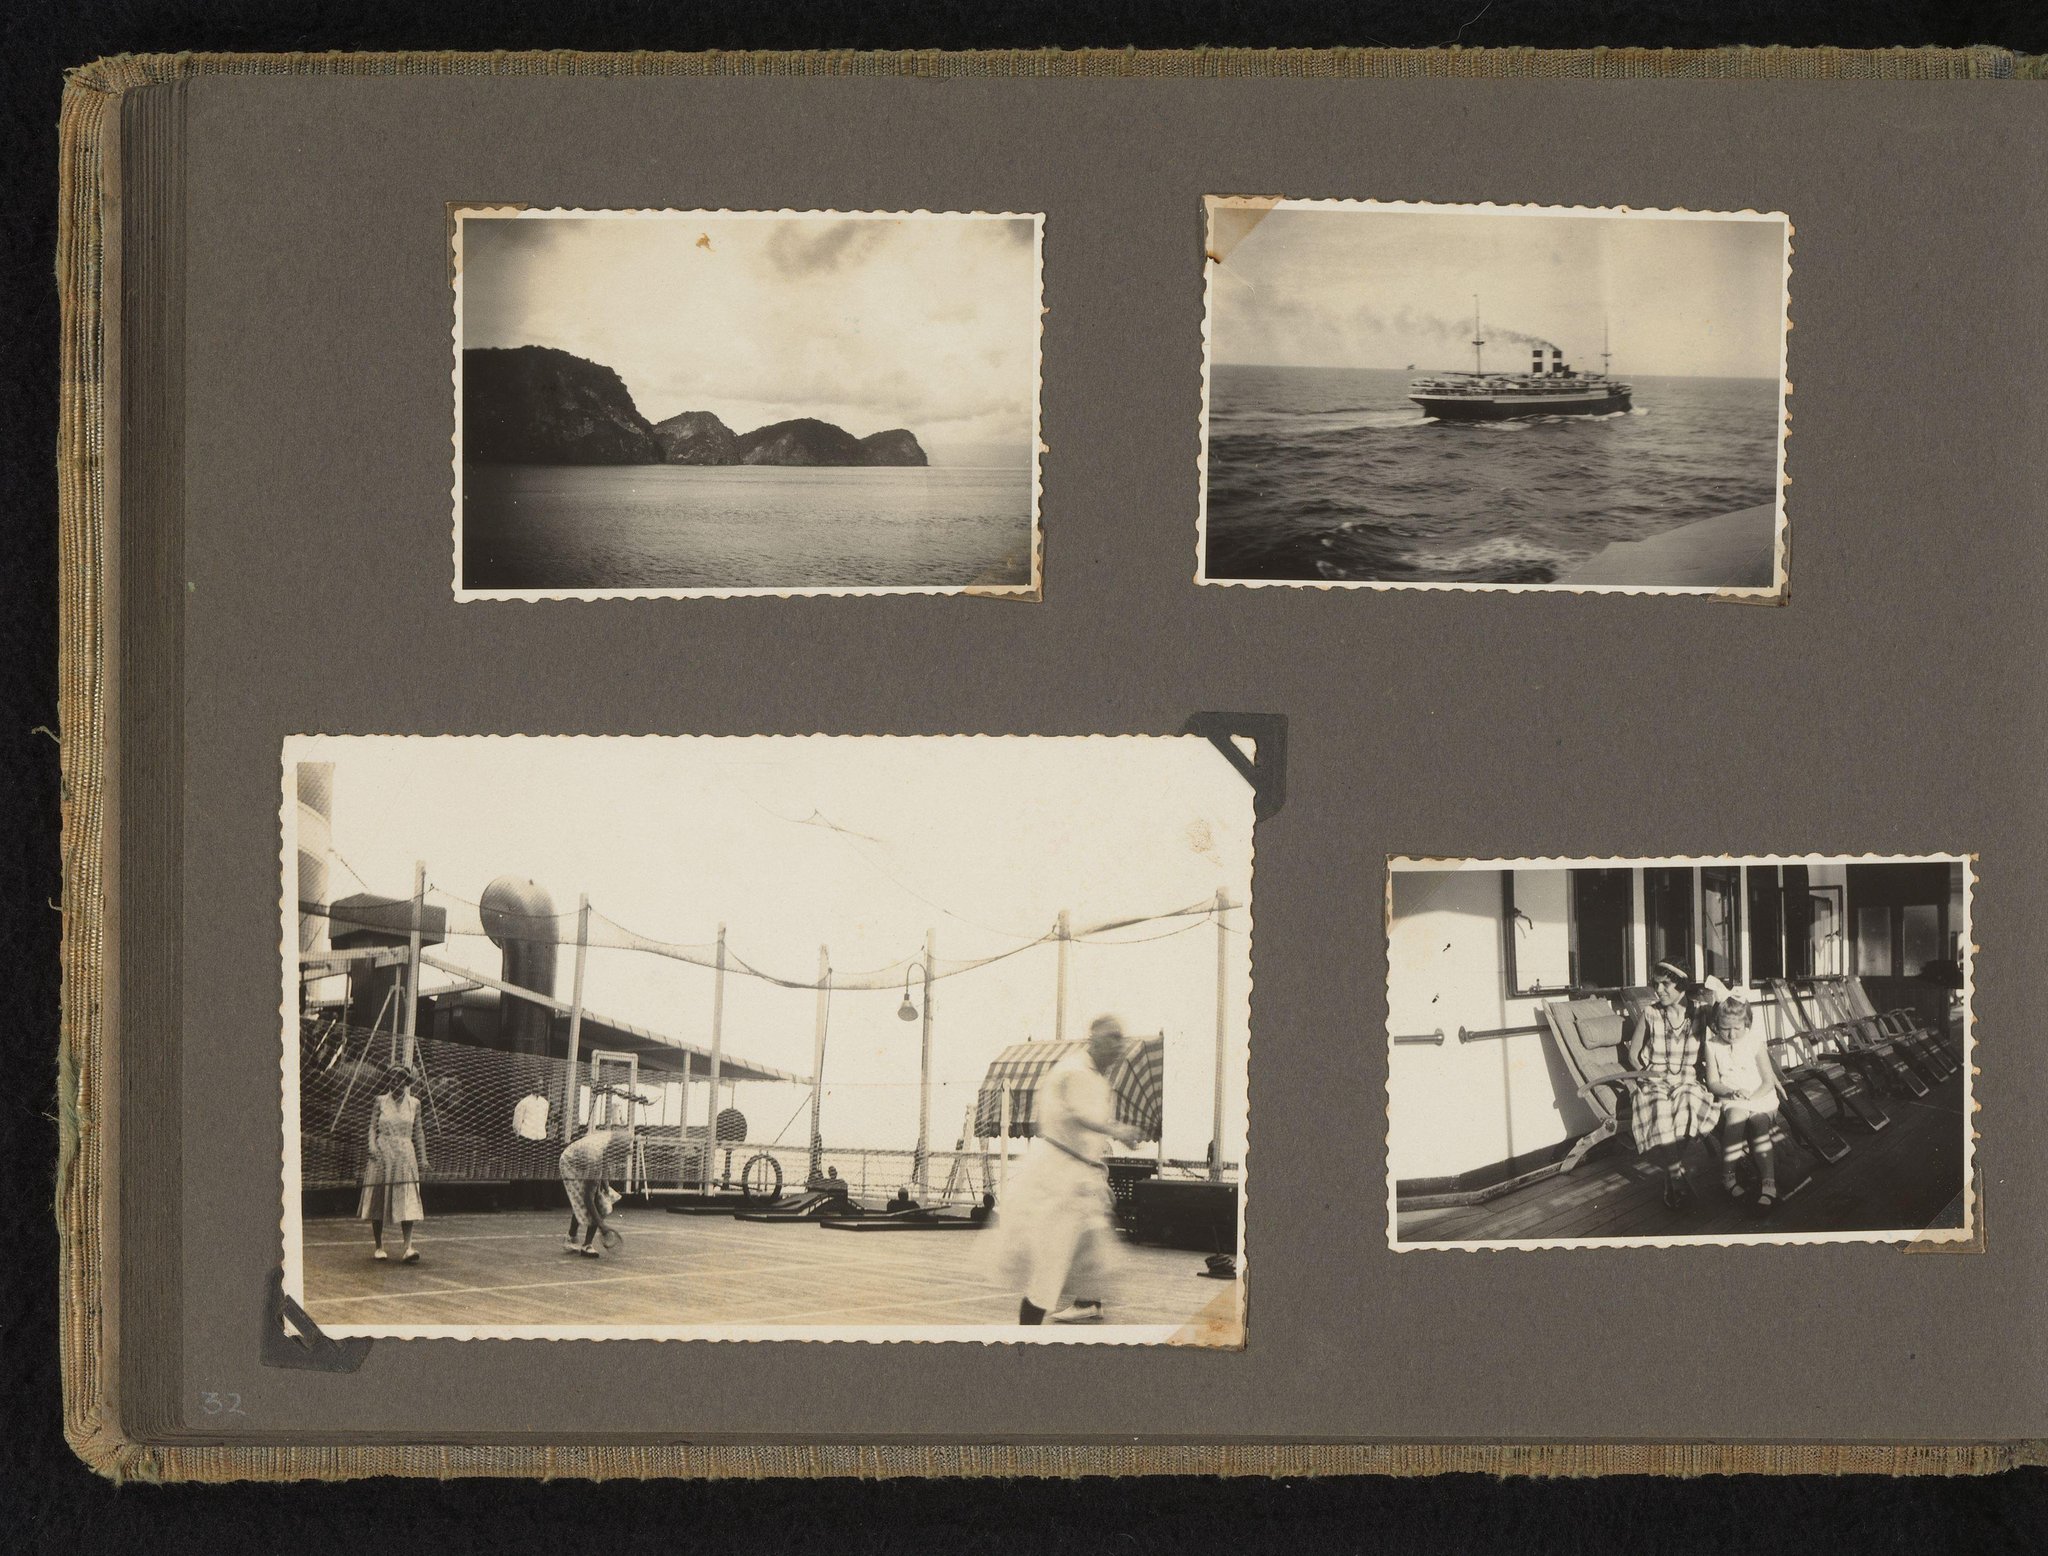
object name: photograph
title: Onderweg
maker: Anonymous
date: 1930-1931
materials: cardboard, photographic support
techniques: gelatin silver print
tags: tennis, lawn-tennis, passengers ~ ship, steamship, motorship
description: Albumblad met vier foto's van activiteiten aan boord van het schip, een kustlandschap en een ander passerend schip. Onderdeel van fotoalbum 'Studentenalbum Indologen'.